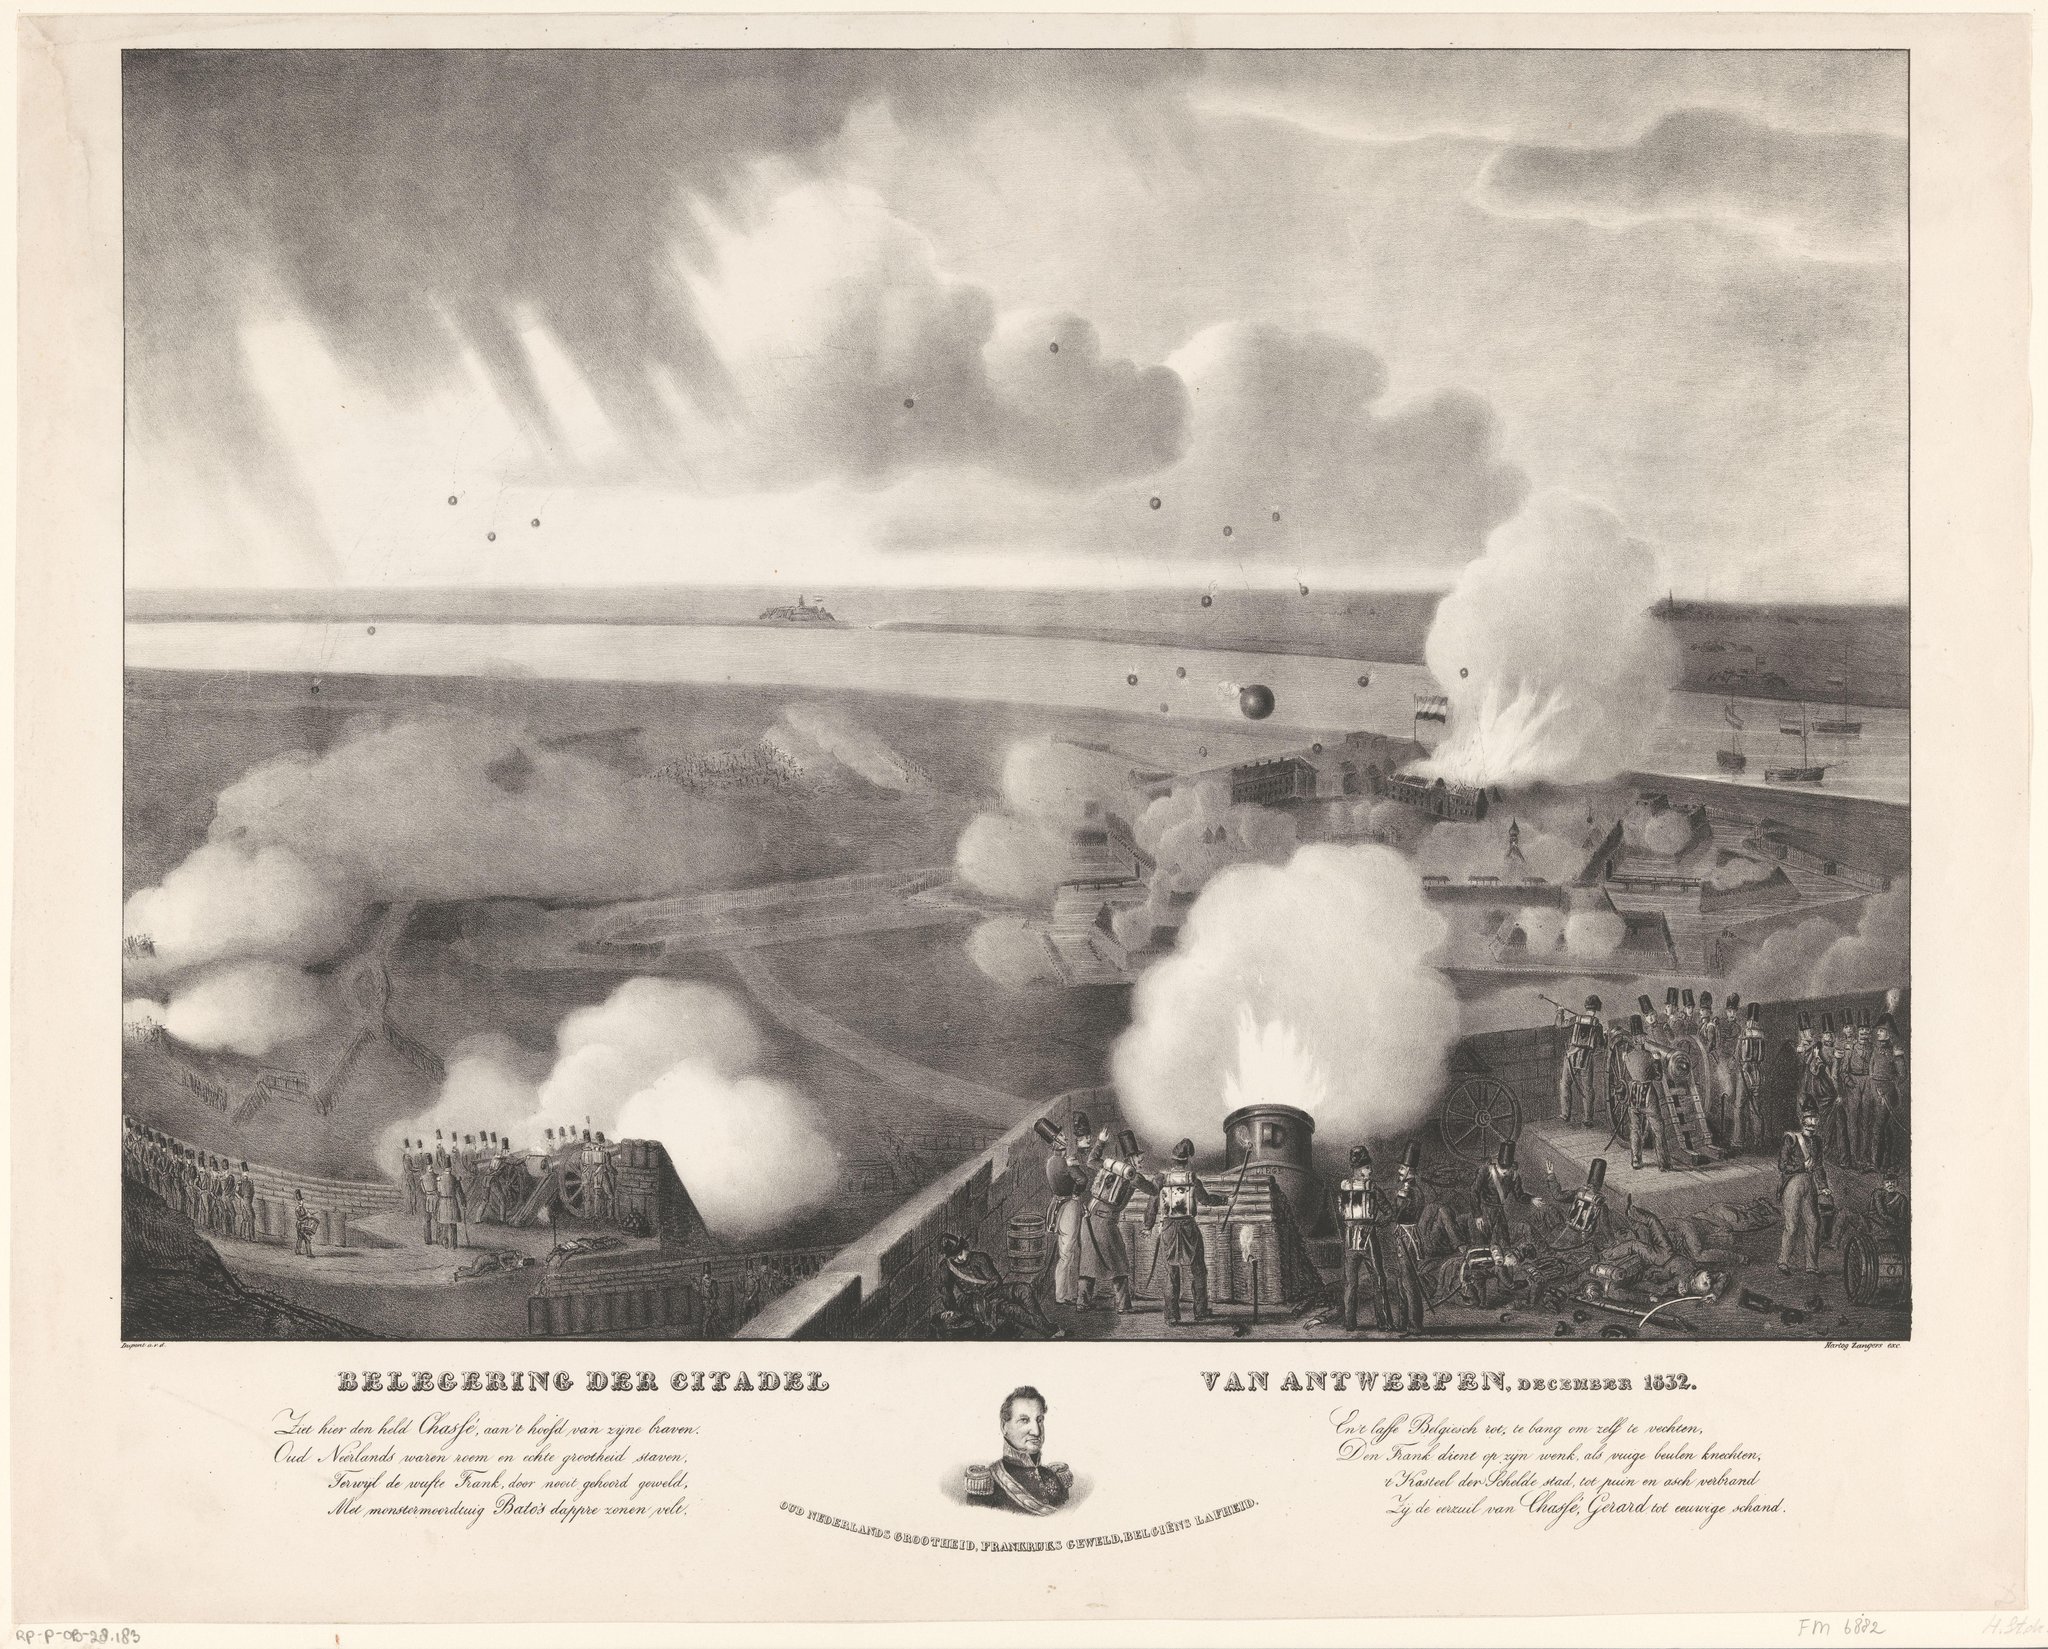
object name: print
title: Beschieting van de Citadel van Antwerpen in 1832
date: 1809-1899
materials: paper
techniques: lithograph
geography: dordrecht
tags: david hendrik baron chassé, inside the besieged city, firearms: cannon, antwerp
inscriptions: collector's mark: Lugt 2228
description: Op de vestingmuren van de stad vuren Franse soldaten kanonnen af. In de voorgrond wordt een zogenaamde monster mortier afgevuurd. De kogels vliegen door de lucht. Rechts ligt de Citadel wat werd verdedigd door de Nederlandse generaal Chassé. In de achtergrond de rivier de Schelde. Onder de afbeelding een onderschrift en het portret van generaal Chassé.